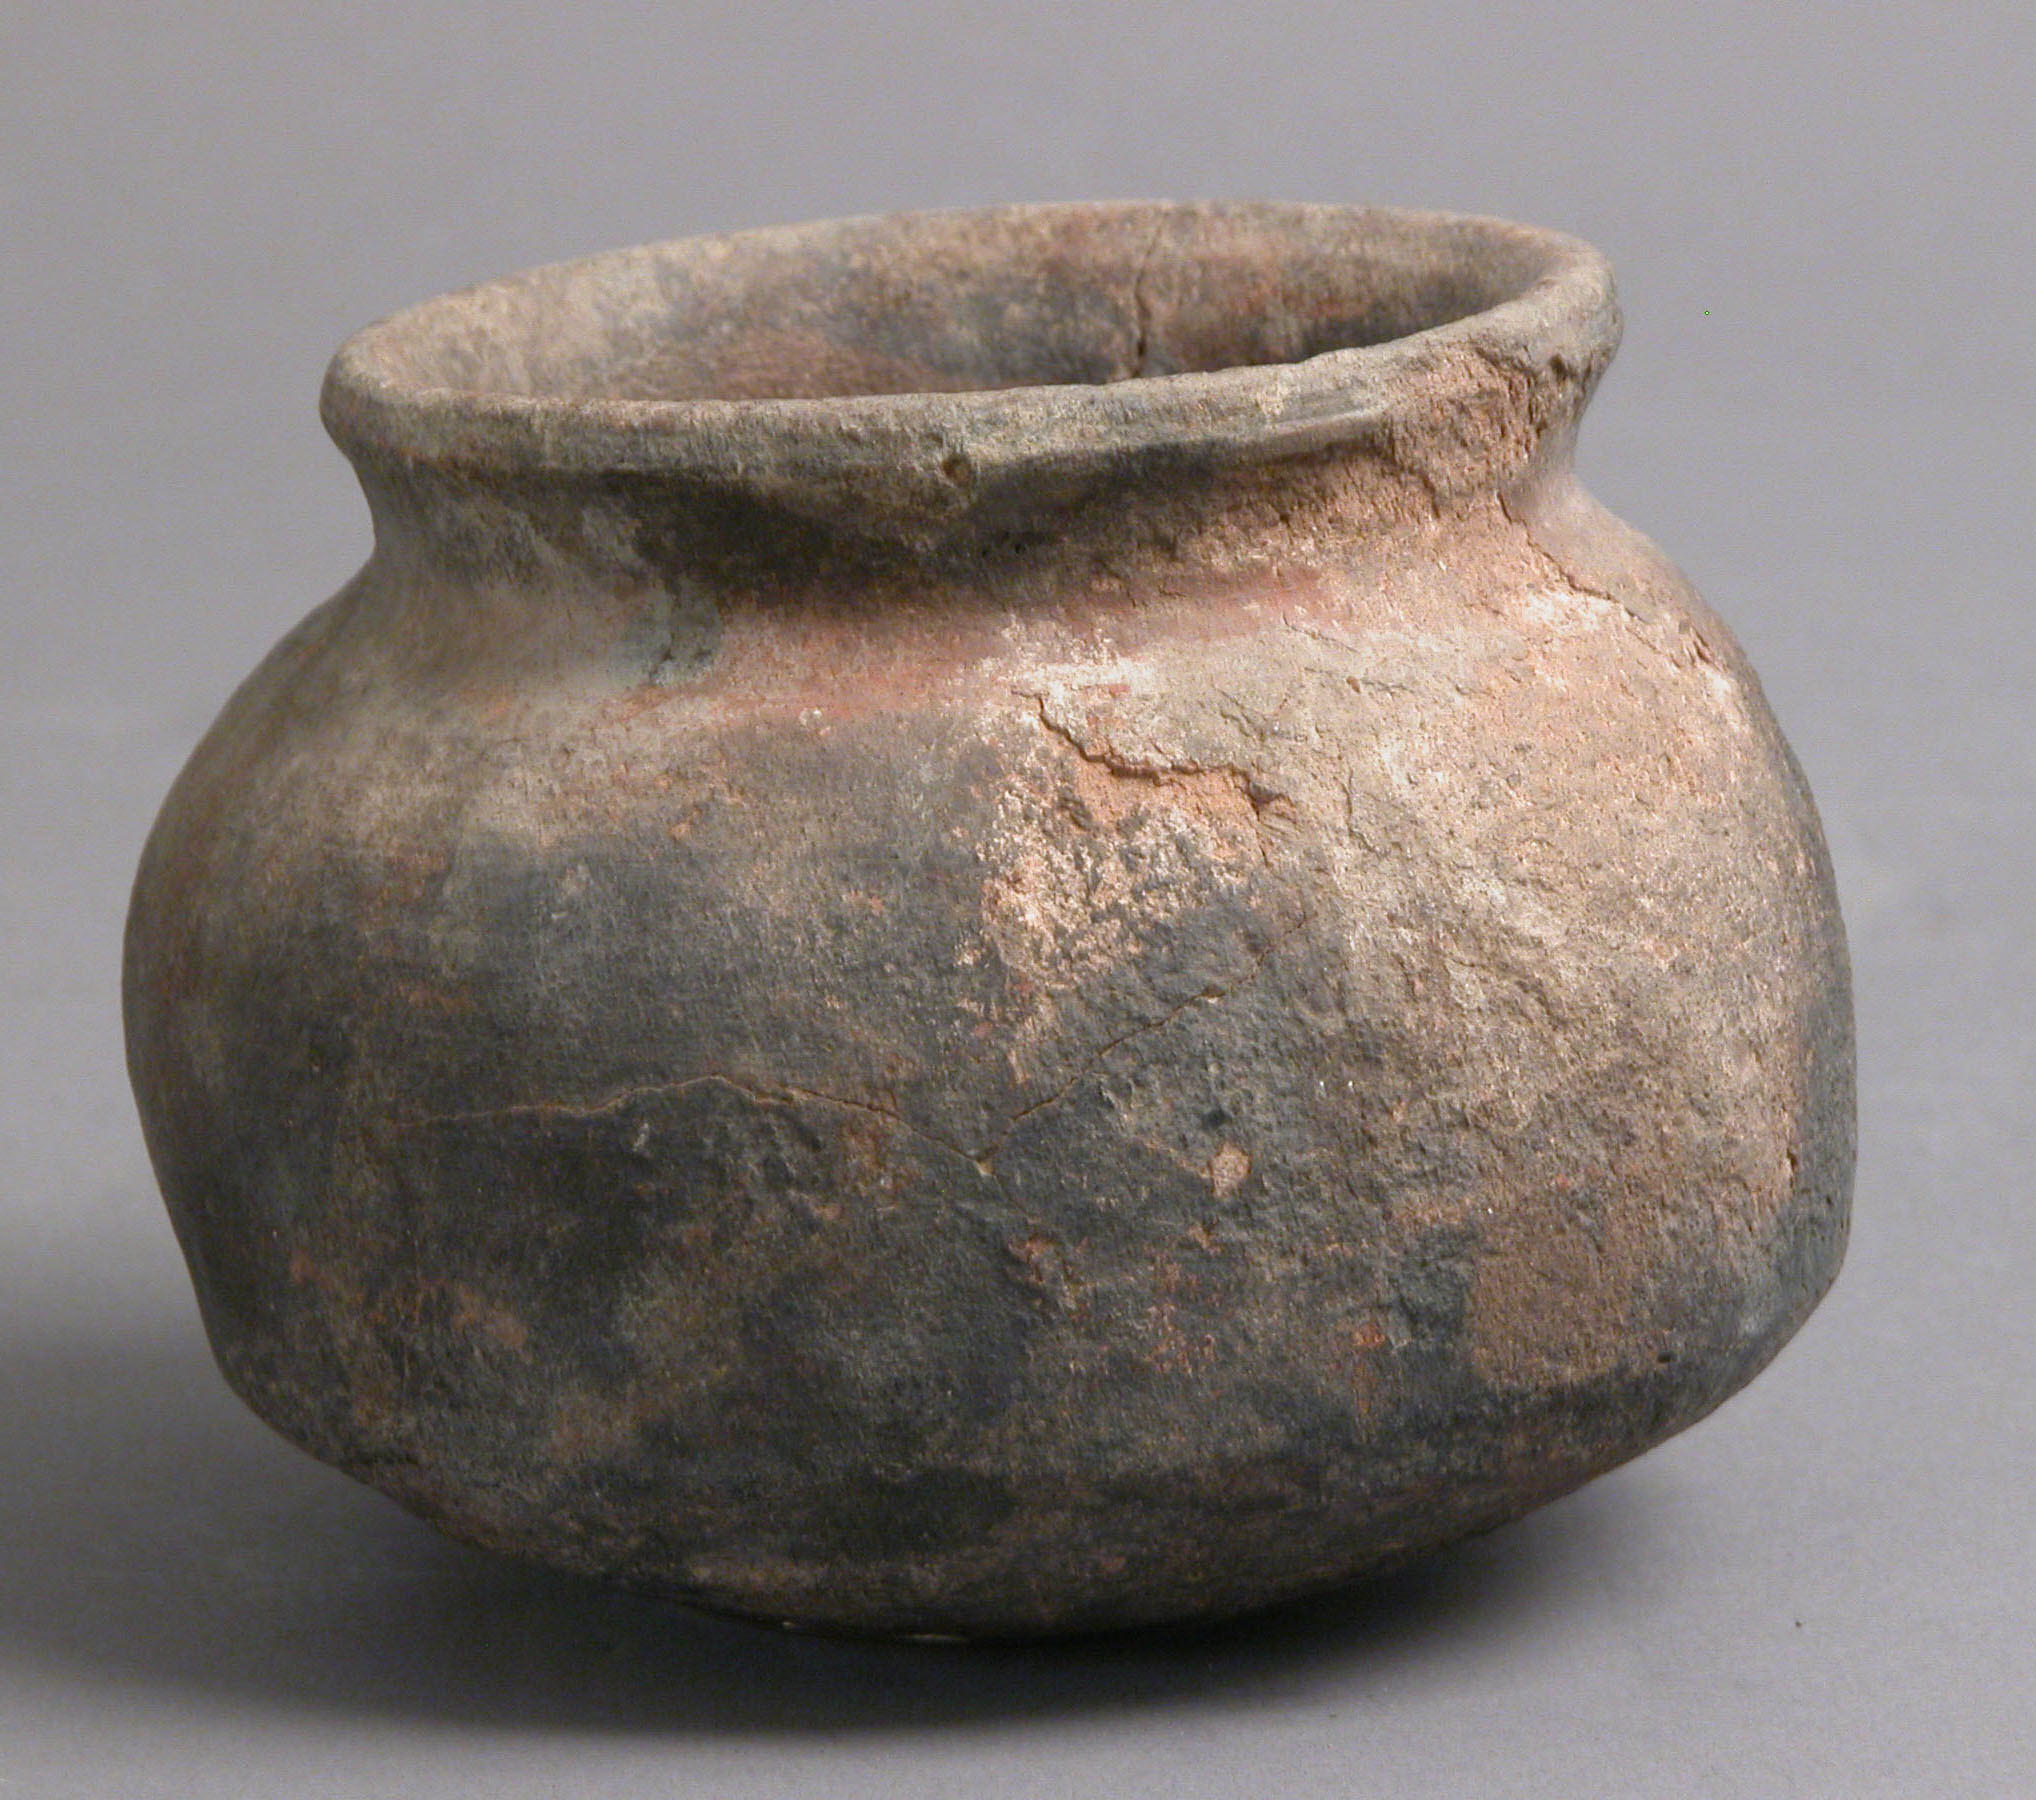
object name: pot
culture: coptic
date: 301-700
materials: earthenware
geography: egypt